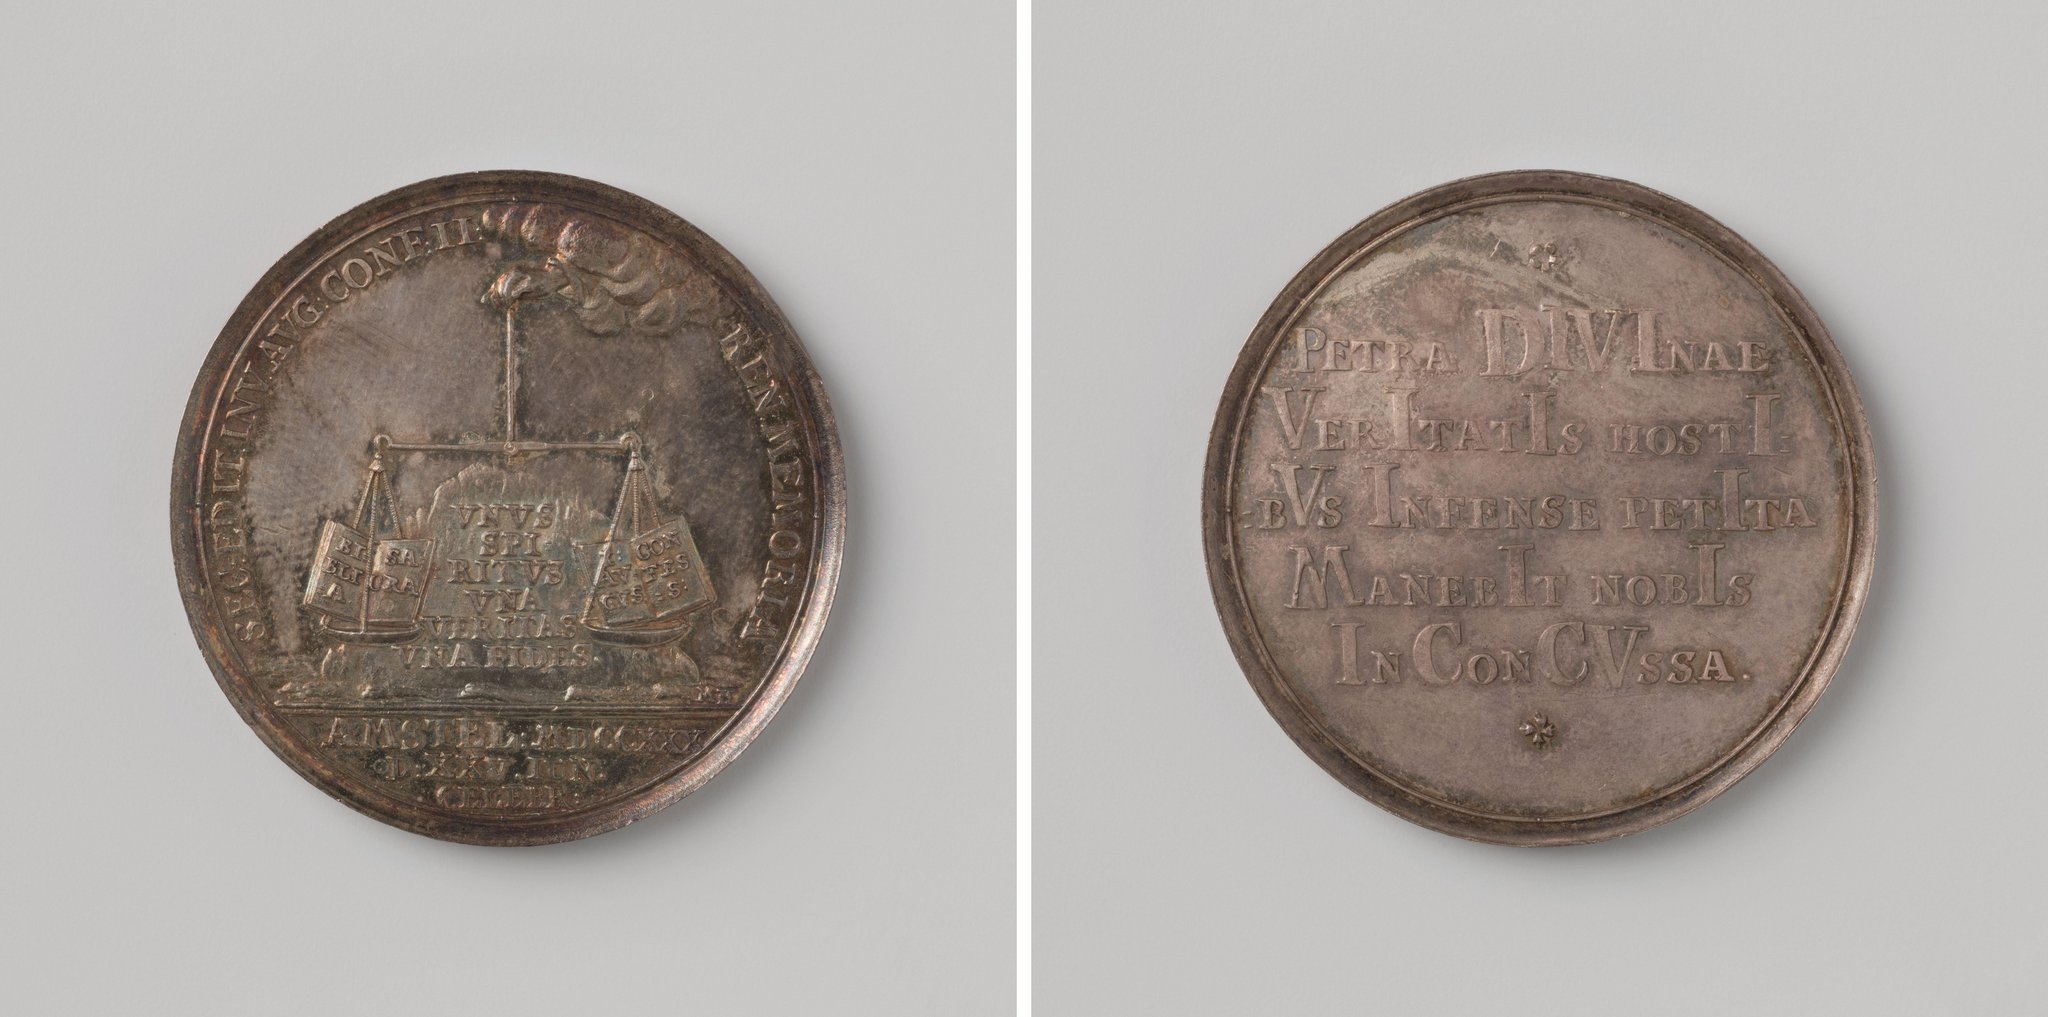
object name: history medal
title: Tweede eeuwfeest op het overleveren van de Augsburgse geloofsbelijdenis op de Rijksdag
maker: martinus holtzhey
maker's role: medailleur, muntmaker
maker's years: 1697-1764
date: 1730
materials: silver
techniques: striking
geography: amsterdam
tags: priest, martin luther, amsterdam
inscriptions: inscription: ‘PETRA DIVINAE/ VERITATIS HOSTI:/ BVS INFENSE PETITA/ MANEBIT NOBIS/ IN CONCVSSA’, inscription: ‘VNVS/ SPI:/RITVS/ VNA/ VERITAS/VNA FIDES.’, circumscription: ‘SEC: EDIT. INV. AVG:CONF: II: REN: MEMORIA’, caption: ‘AMSTEL; MDCCXXX/ D:XXV.IUN./ CELEBR:’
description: Zilveren penning. Voorzijde: op weegschaal die door hand uit wolken vastgehouden wordt, houden bijbel en Augsburgse geloofsbelijdenis elkaar in evenwicht, tussen beide schalen in rots met opschrift binnen omschrift; afsnede: opschrift. Keerzijde: opschrift tussen twee bloempunten.